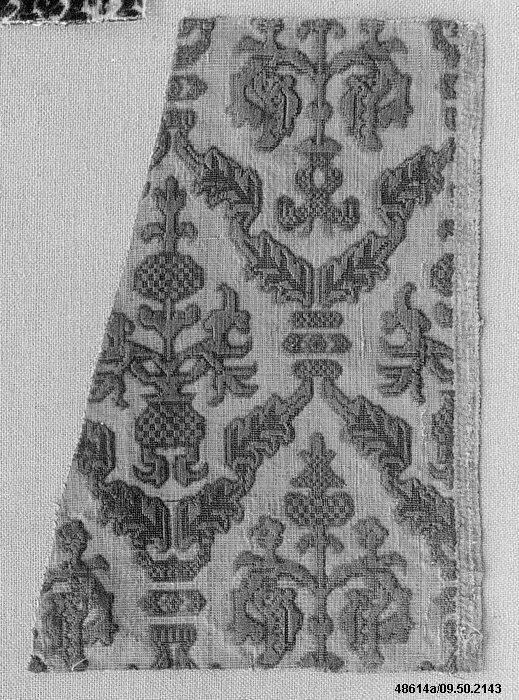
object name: piece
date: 1501-1700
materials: metal thread, silk